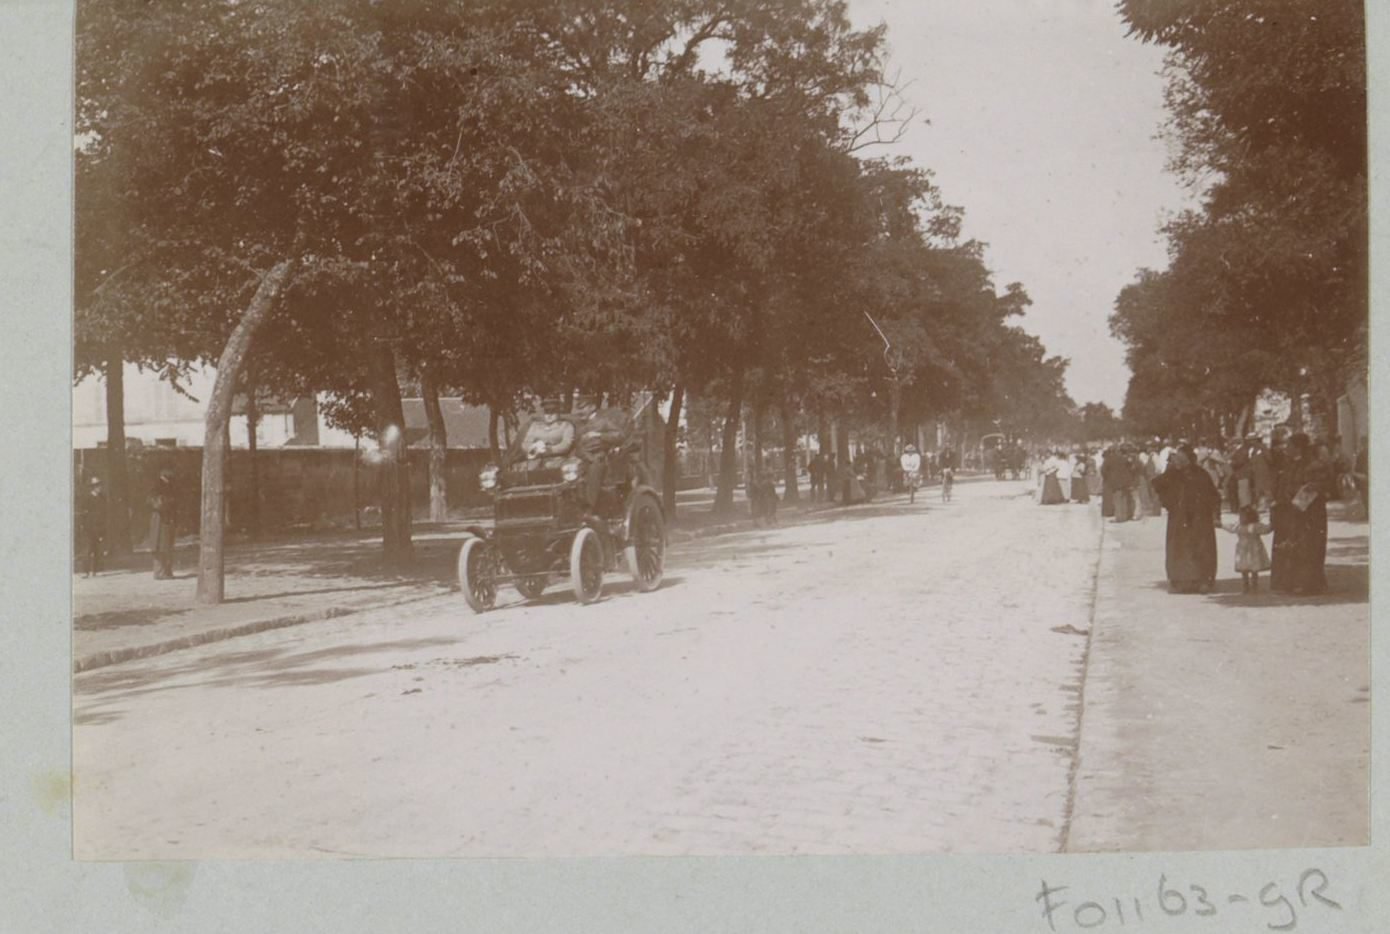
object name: photograph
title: Start van de race Parijs-Amsterdam voor automobielen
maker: delizy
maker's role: manufacturer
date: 1898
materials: paper, photographic support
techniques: gelatin silver print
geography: paris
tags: motorcar racing, automobile, street (+ city(-scape) with figures, staffage), paris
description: Onderdeel van Fotoalbum van een Franse amateurfotograaf met opnames van uitstapjes in Frankrijk, Spanje, België, Luxemburg en Nederland, de eerste automobielen en autoraces.